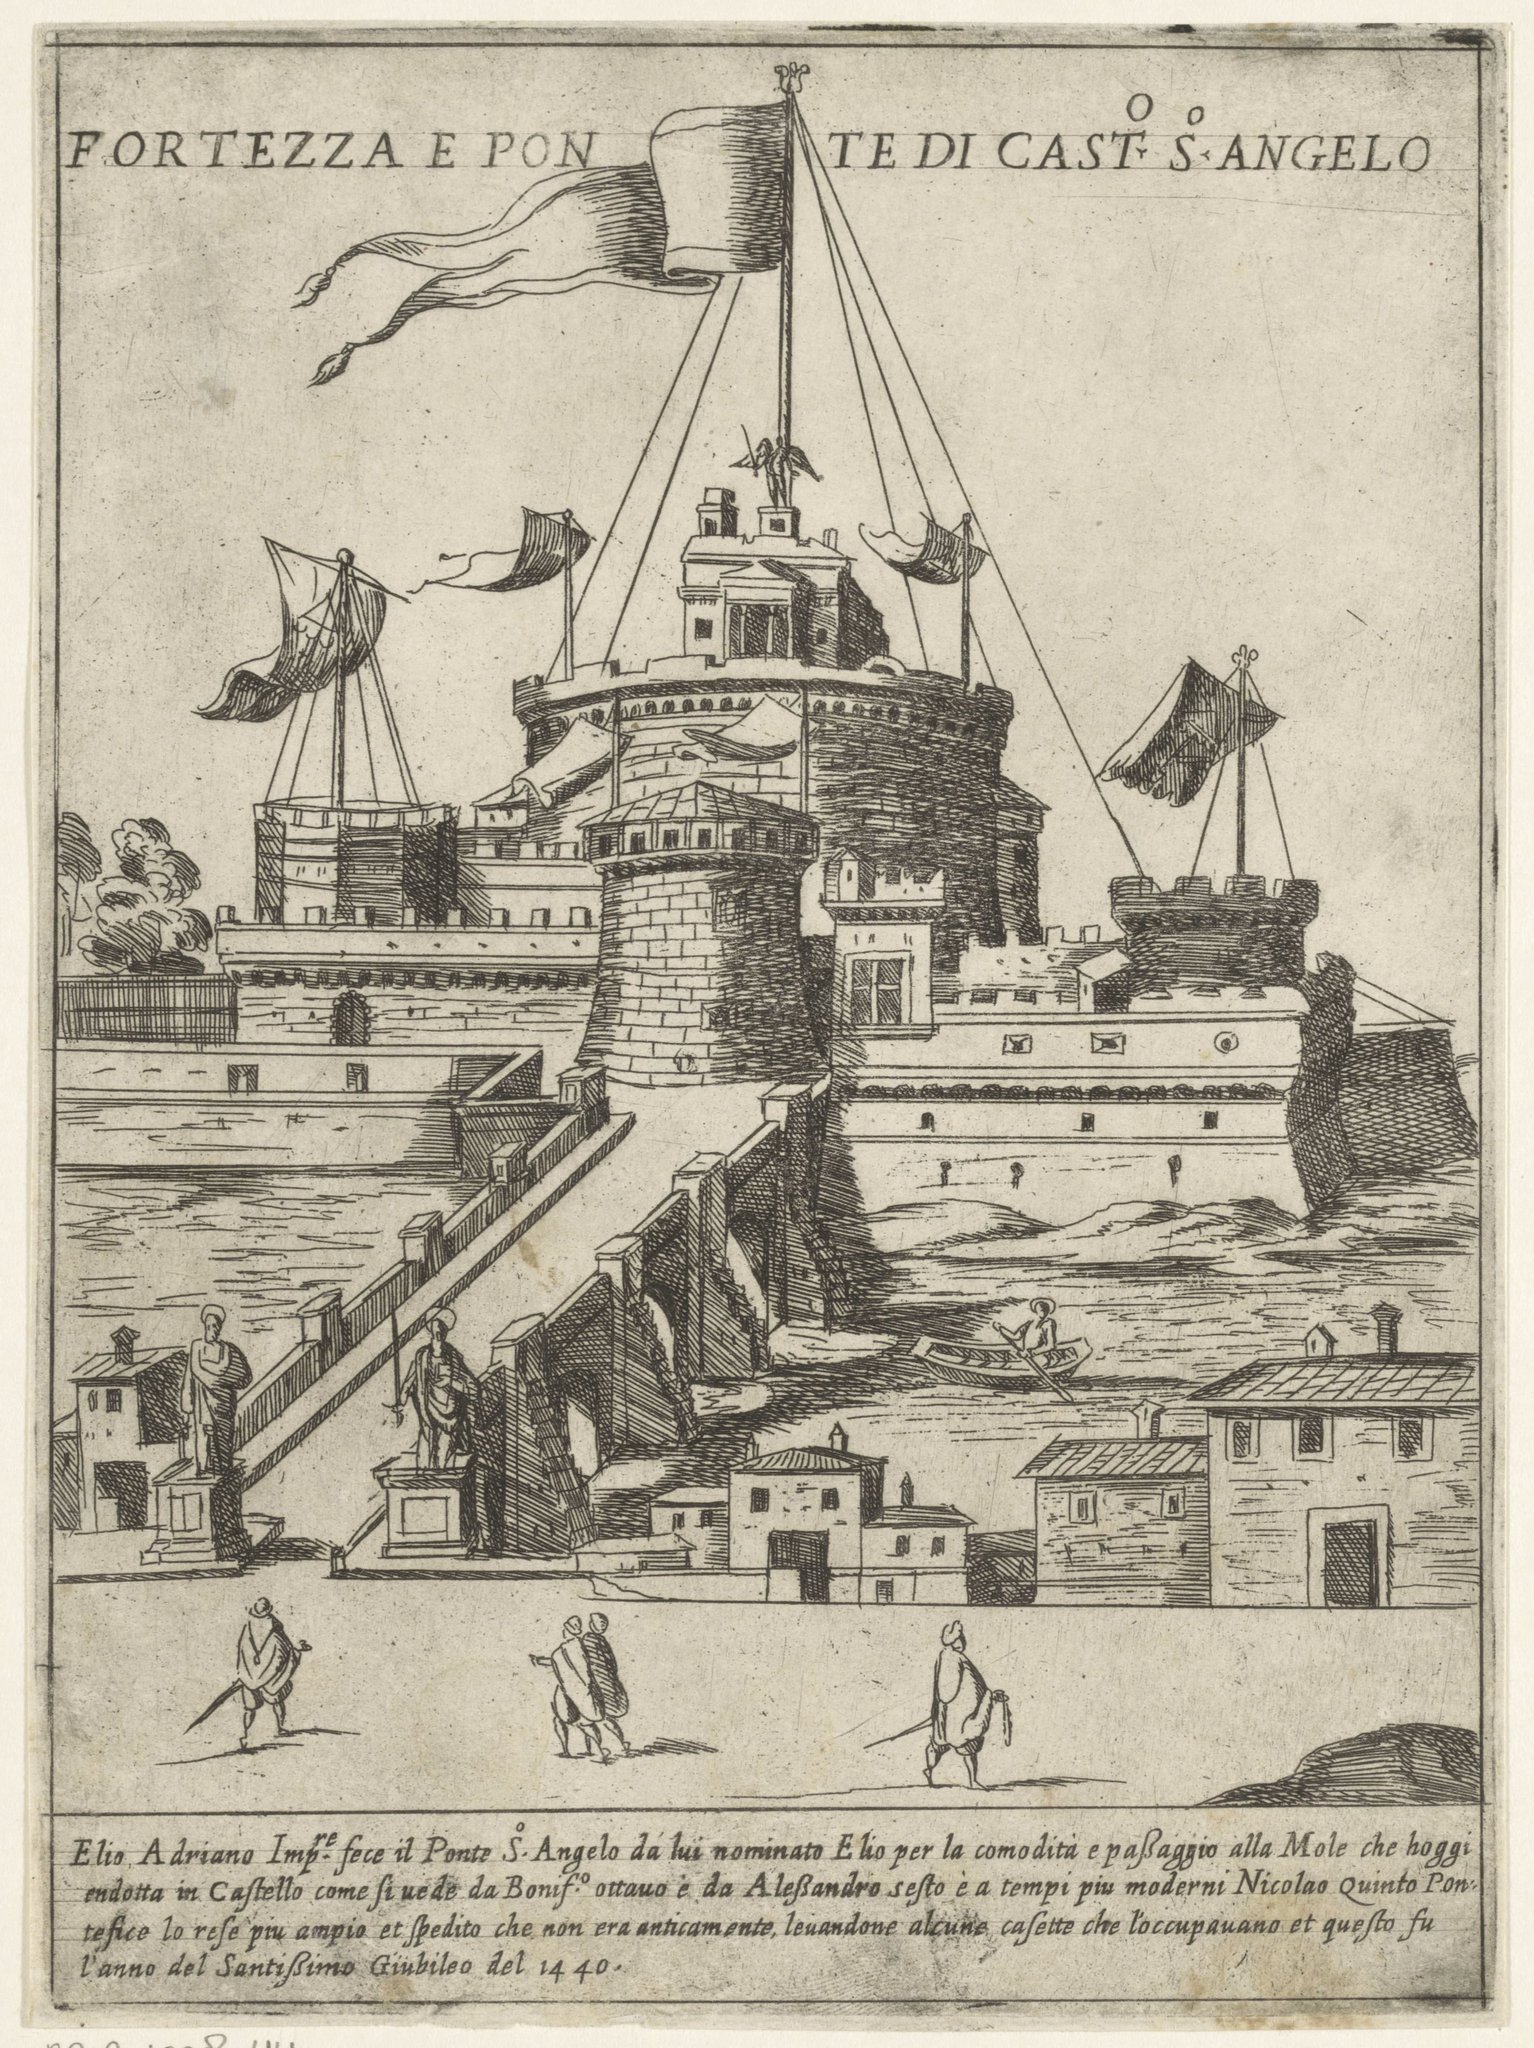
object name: print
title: Fortezza e ponte di Cast.o S.o Angelo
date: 1576-1618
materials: paper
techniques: etching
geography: rome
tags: fortress, bridge, rome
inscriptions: collector's mark: Lugt 2228, collector's mark: Lugt 1337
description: Gezicht op de Engelenburcht en de Engelenbrug over de rivier de Tiber te Rome. Italiaanse tekst in ondermarge.